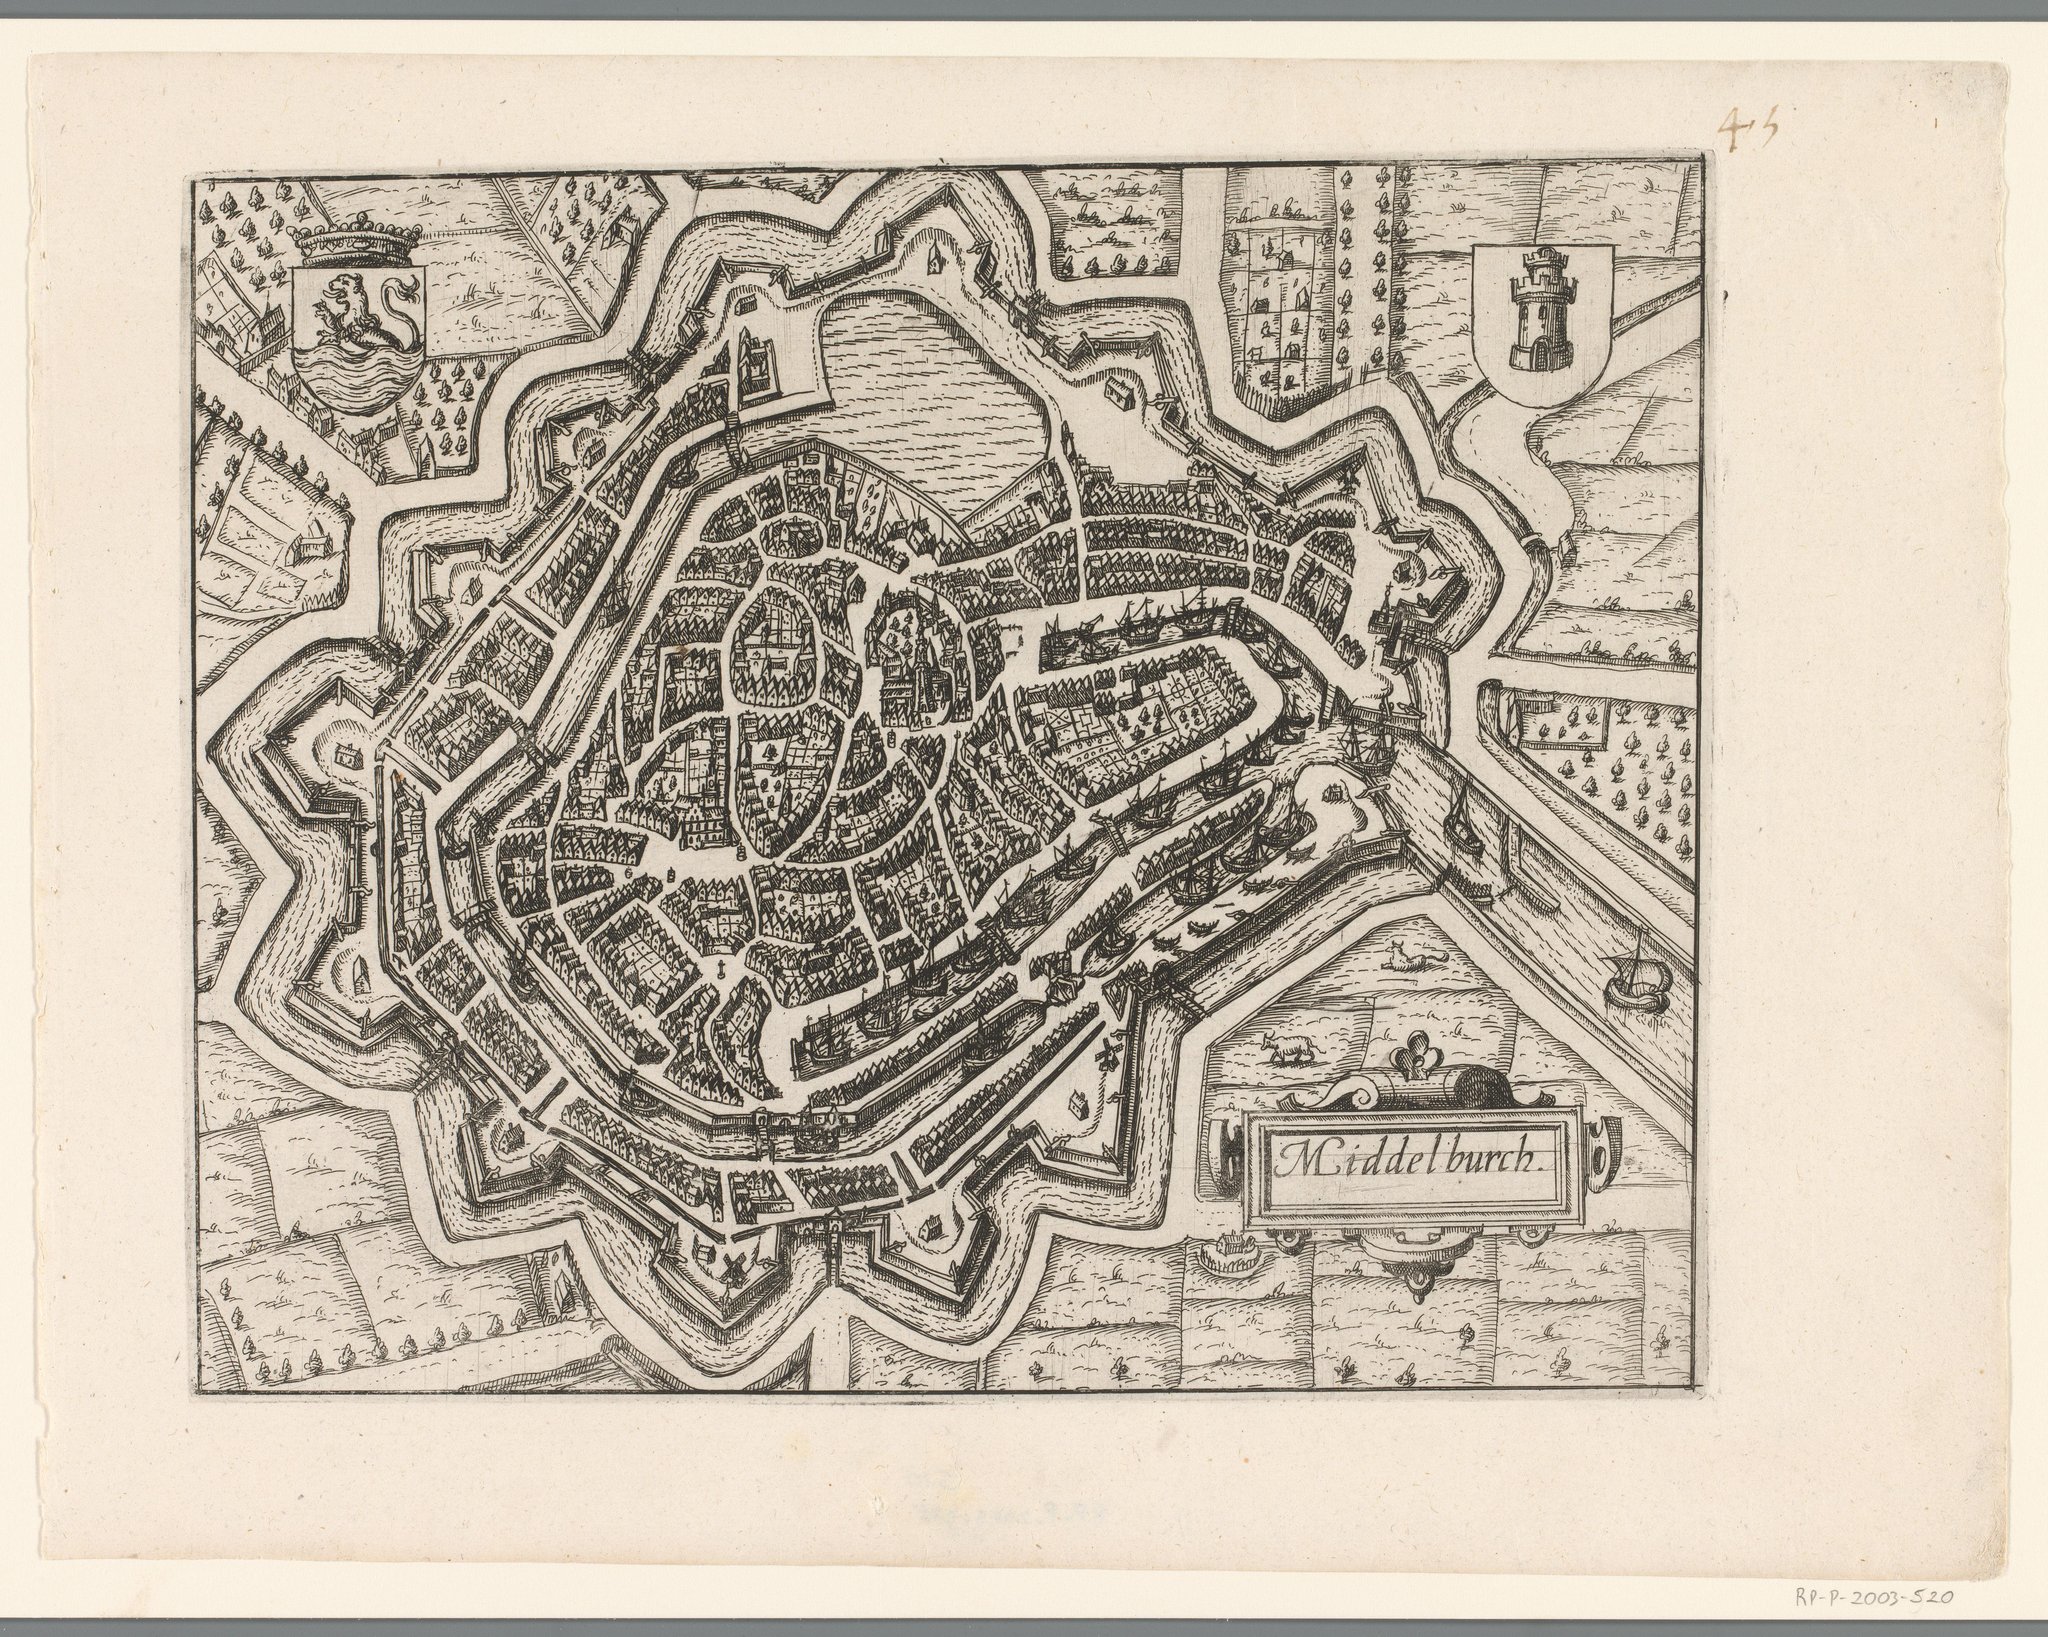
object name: area plan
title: Middelburch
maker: Anonymous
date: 1607-1609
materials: paper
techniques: etching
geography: northern netherlands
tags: maps of cities, middelburg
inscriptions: number: ‘45’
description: Plattegrond van de stad Middelburg in Zeeland. Linksboven het provinciewapen van Zeeland, rechtsboven het stadswapen. Rechtsonder een cartouche met de titel. Onderdeel van de verzameling kaarten genomen uit een latere editie van: Descrittione di tutti i Paesi Bassi van Lodovico Guicciardini.